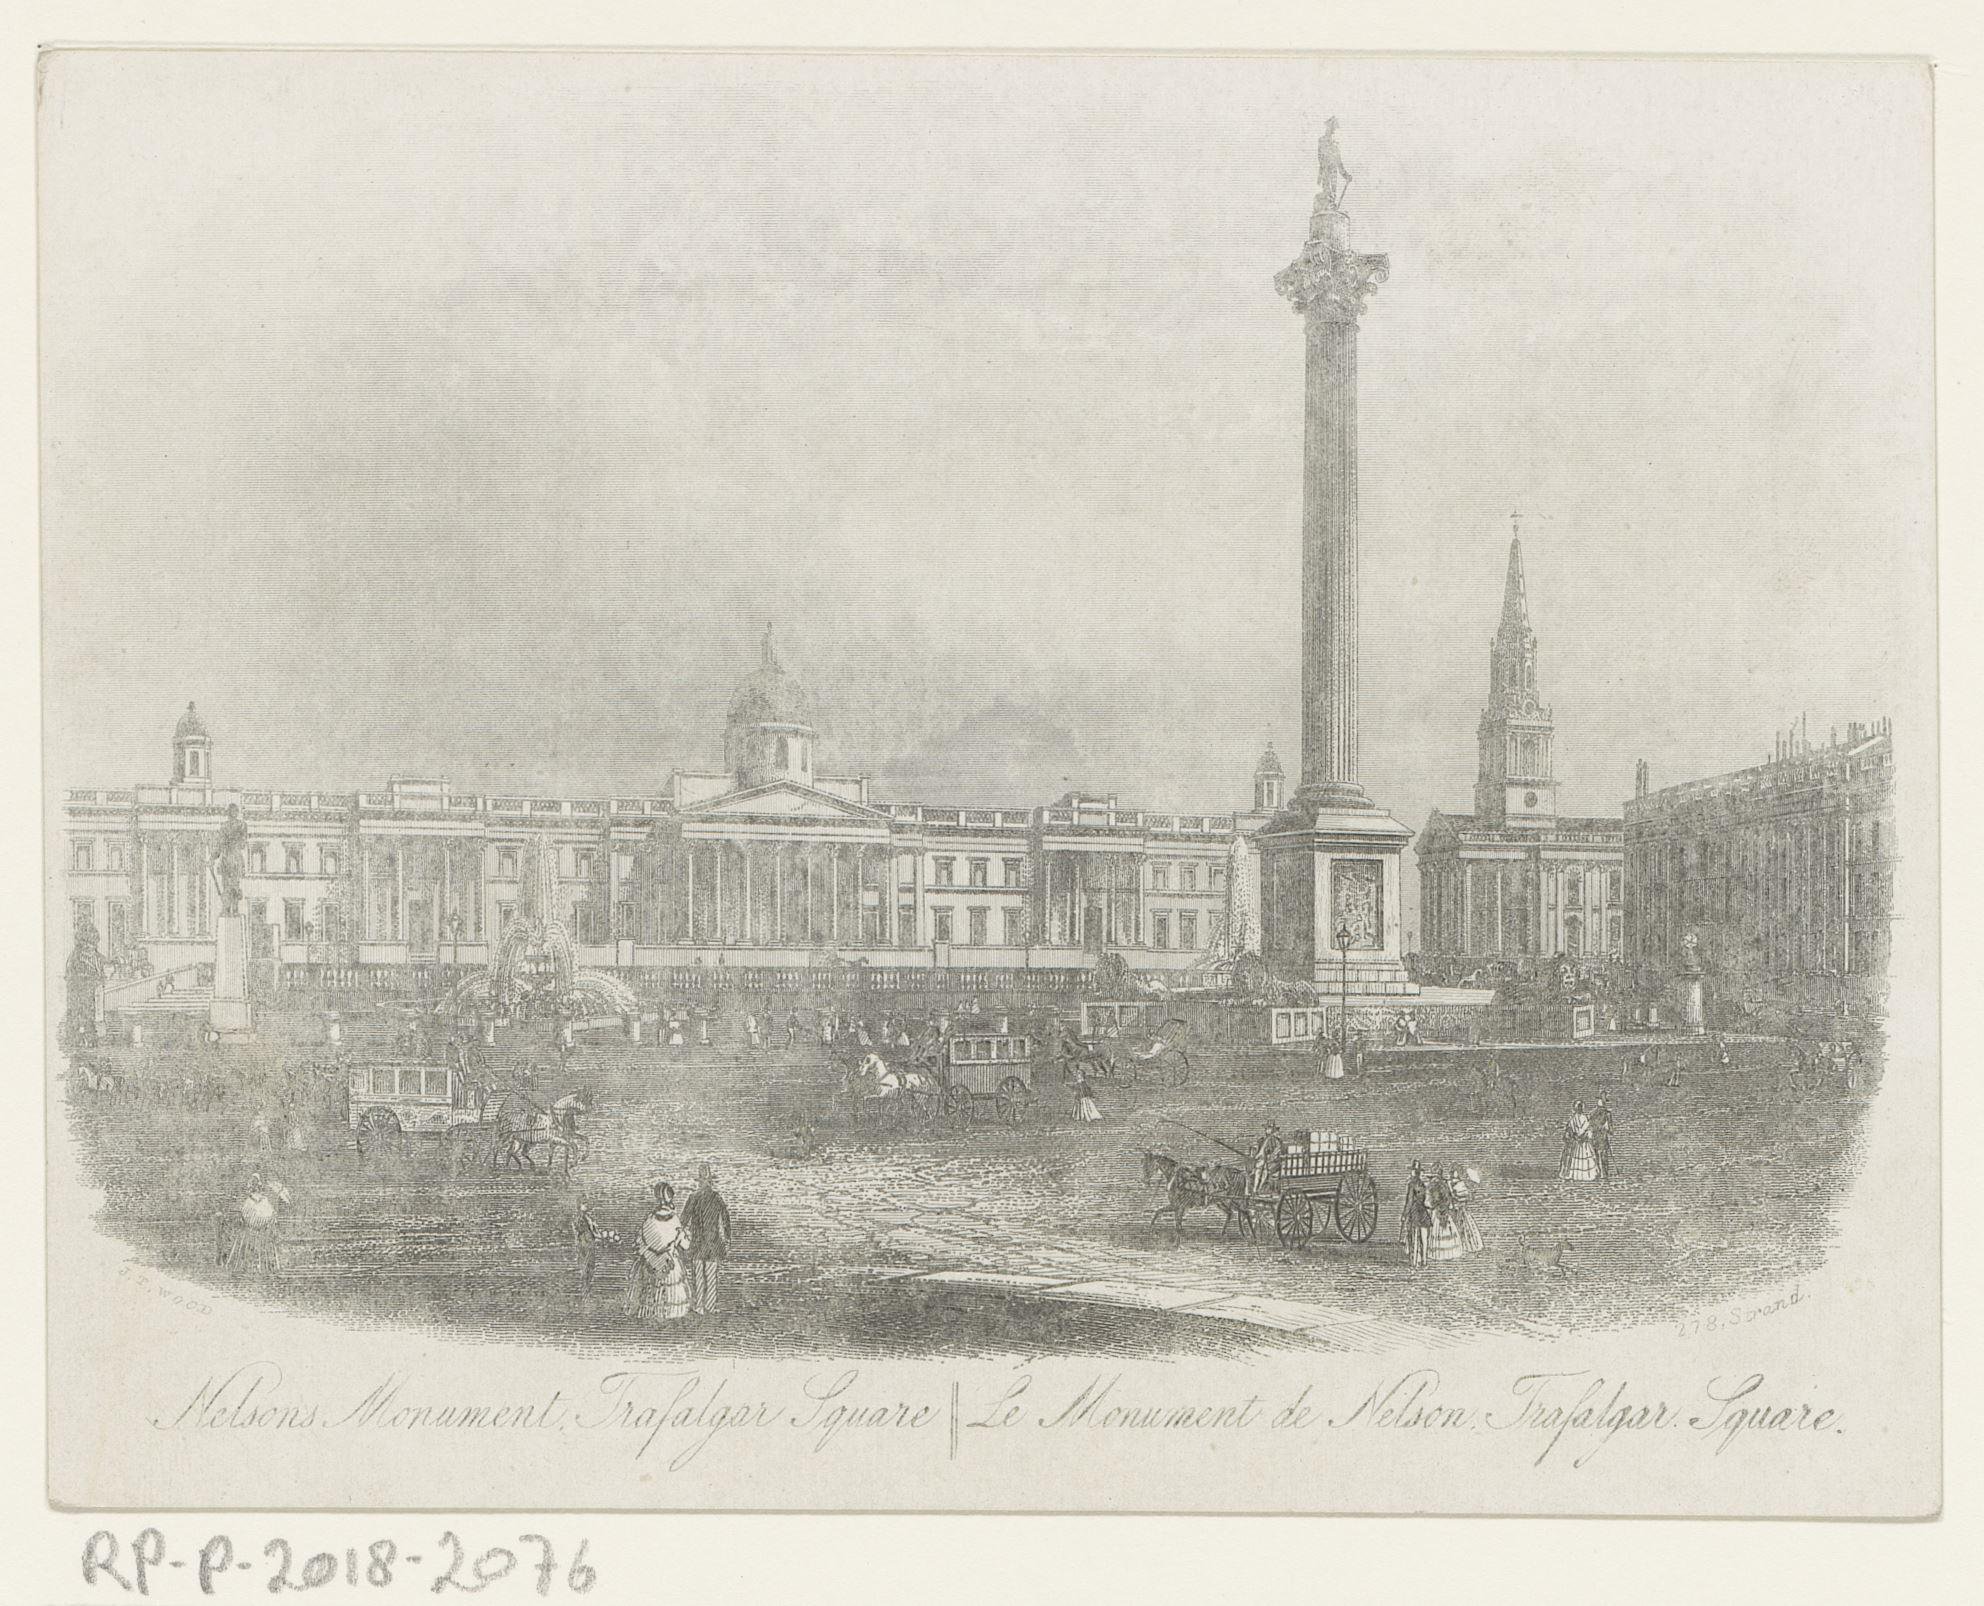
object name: print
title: Gezicht op Nelson's Column, te Londen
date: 1843-1885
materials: paper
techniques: etching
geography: london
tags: column, pillar ~ architecture, monument, statue